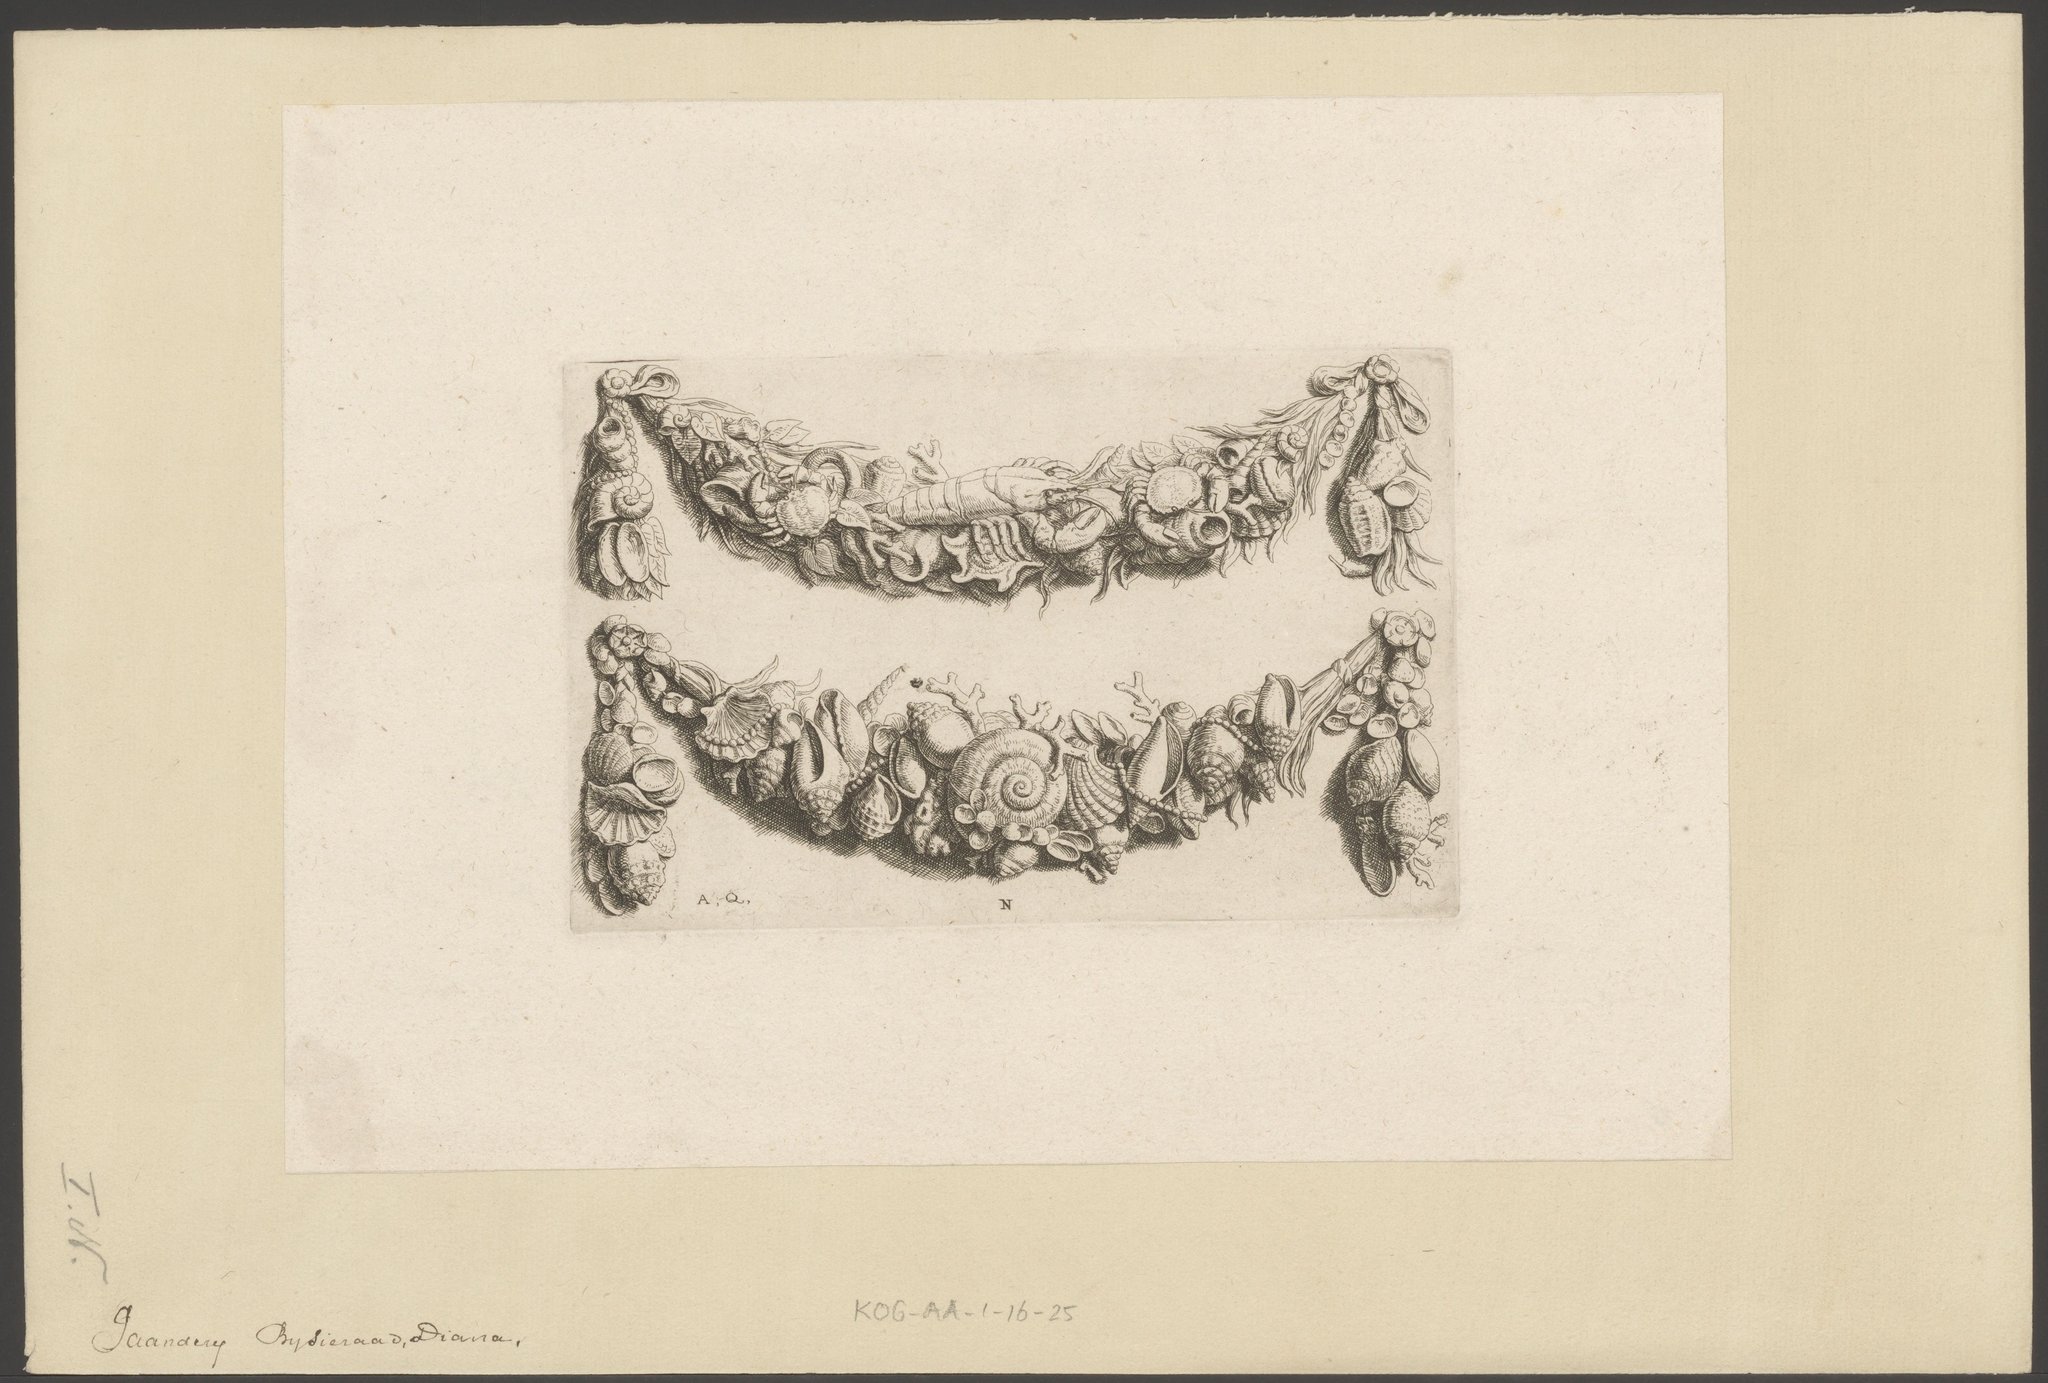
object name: print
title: Twee festoenen met schaaldieren en schelpen in de oostelijke galerij van het Stadhuis op de Dam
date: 1655-1665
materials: paper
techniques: engraving, etching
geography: amsterdam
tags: crustaceans, townhall, molluscs (+ shell, snail-shell etc.), ornament ~ festoon, garland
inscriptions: collector's mark: ‘16,25’ Lugt 1641b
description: Prent gebruikt in: Prima pars. Praecipuarum effigierum ac ornamentorum, amplissimae Curiae Amstelrodamensis (…) / Het eerste deel. Van de voornaemste Statuen ende Ciraten, vant konstijck Stadhuys van Amstelredam, tmeeste in marmer gemaeckt, door Artus Quellinus, Beelthouwer der voorseyde Stadt / La Premier Partie. De plusieurs Figures et ornements, de la Maison de Ville d'Amsterdam (…). Amsterdam: Artus Quellinus (I), 1655. Zie RP-P-AO-22-1-1 voor bijhorende titelpagina. Zie RP-P-AO-22-1-2 voor bijhorend register. Zie RP-P-AO-22-1A, RP-P-AO-22-1B, RP-P-AO-22-1C, RP-P-AO-22-1D-1, RP-P-AO-22-1D-2, RP-P-AO-22-1E, RP-P-AO-22-1F, RP-P-AO-22-1G, RP-P-AO-22-1H, RP-P-AO-22-1I, RP-P-AO-22-1K-1, RP-P-AO-22-1K-2, RP-P-AO-22-1K-3, RP-P-AO-22-1K-4, RP-P-AO-22-1K-5, RP-P-AO-22-1L-1, RP-P-AO-22-1L-2, RP-P-AO-22-1M-1, RP-P-AO-22-1M-2, RP-P-AO-22-1N-1, RP-P-AO-22-1N-2, RP-P-AO-22-1N-3, RP-P-AO-22-1N-4, RP-P-AO-22-1O-1, RP-P-AO-22-1O-2, RP-P-AO-22-1O-3, RP-P-AO-22-1O-4, RP-P-AO-22-1P-1, RP-P-AO-22-1P-2, RP-P-AO-22-1P-3, RP-P-AO-22-1P-4, RP-P-AO-22-1Q-1, RP-P-AO-22-1Q-2, RP-P-AO-22-1Q-3, RP-P-AO-22-1Q-4, RP-P-AO-22-1R-1, RP-P-AO-22-1R-2, RP-P-AO-22-1R-3, RP-P-AO-22-1R-4, RP-P-AO-22-1R-5, RP-P-AO-22-1S-1, RP-P-AO-22-1S-2, RP-P-AO-22-1S-3, RP-P-AO-22-1S-4, RP-P-AO-22-1S-5, RP-P-AO-22-1T-1 en RP-P-AO-22-1T-2 voor andere prenten uit deze publicatie. Zelfde staat van prent ook gebruikt in: Prima pars. Praecipuarum effigierum ac ornamentorum, amplissimae Curiae Amstelrodamensis (…) / Het eerste deel. Van de voornaemste Statuen ende Ciraten, vant konstijck Stadhuys van Amstelredam, tmeeste in marmer gemaeckt, door Artus Quellinus, Beelthouwer der voorseyde Stadt / La Premier Partie. De plusieurs Figures et ornements, de la Maison de Ville d'Amsterdam (…). Amsterdam: Frederik de Wit, 1665. Latere staat van prent ook gebruikt in: Architecture peinture et sculpture de la Maison de Ville d'Amsterdam, representee en CIX. figures en taille-douce (…). Amsterdam: David Mortier, 1719. En in: Architecture peinture et sculpture de la Maison de Ville d'Amsterdam, representee en CIX. figures en taille-douce (…). Amsterdam: Gerard Valck, 1719. En in: Bouw schilder en beeldhouwkonst, van het Stadhuis te Amsteldam, vertoont in CIX figuuren (…). Amsterdam: Covens & Mortier & Covens Jr., s.a. (1774-1783).